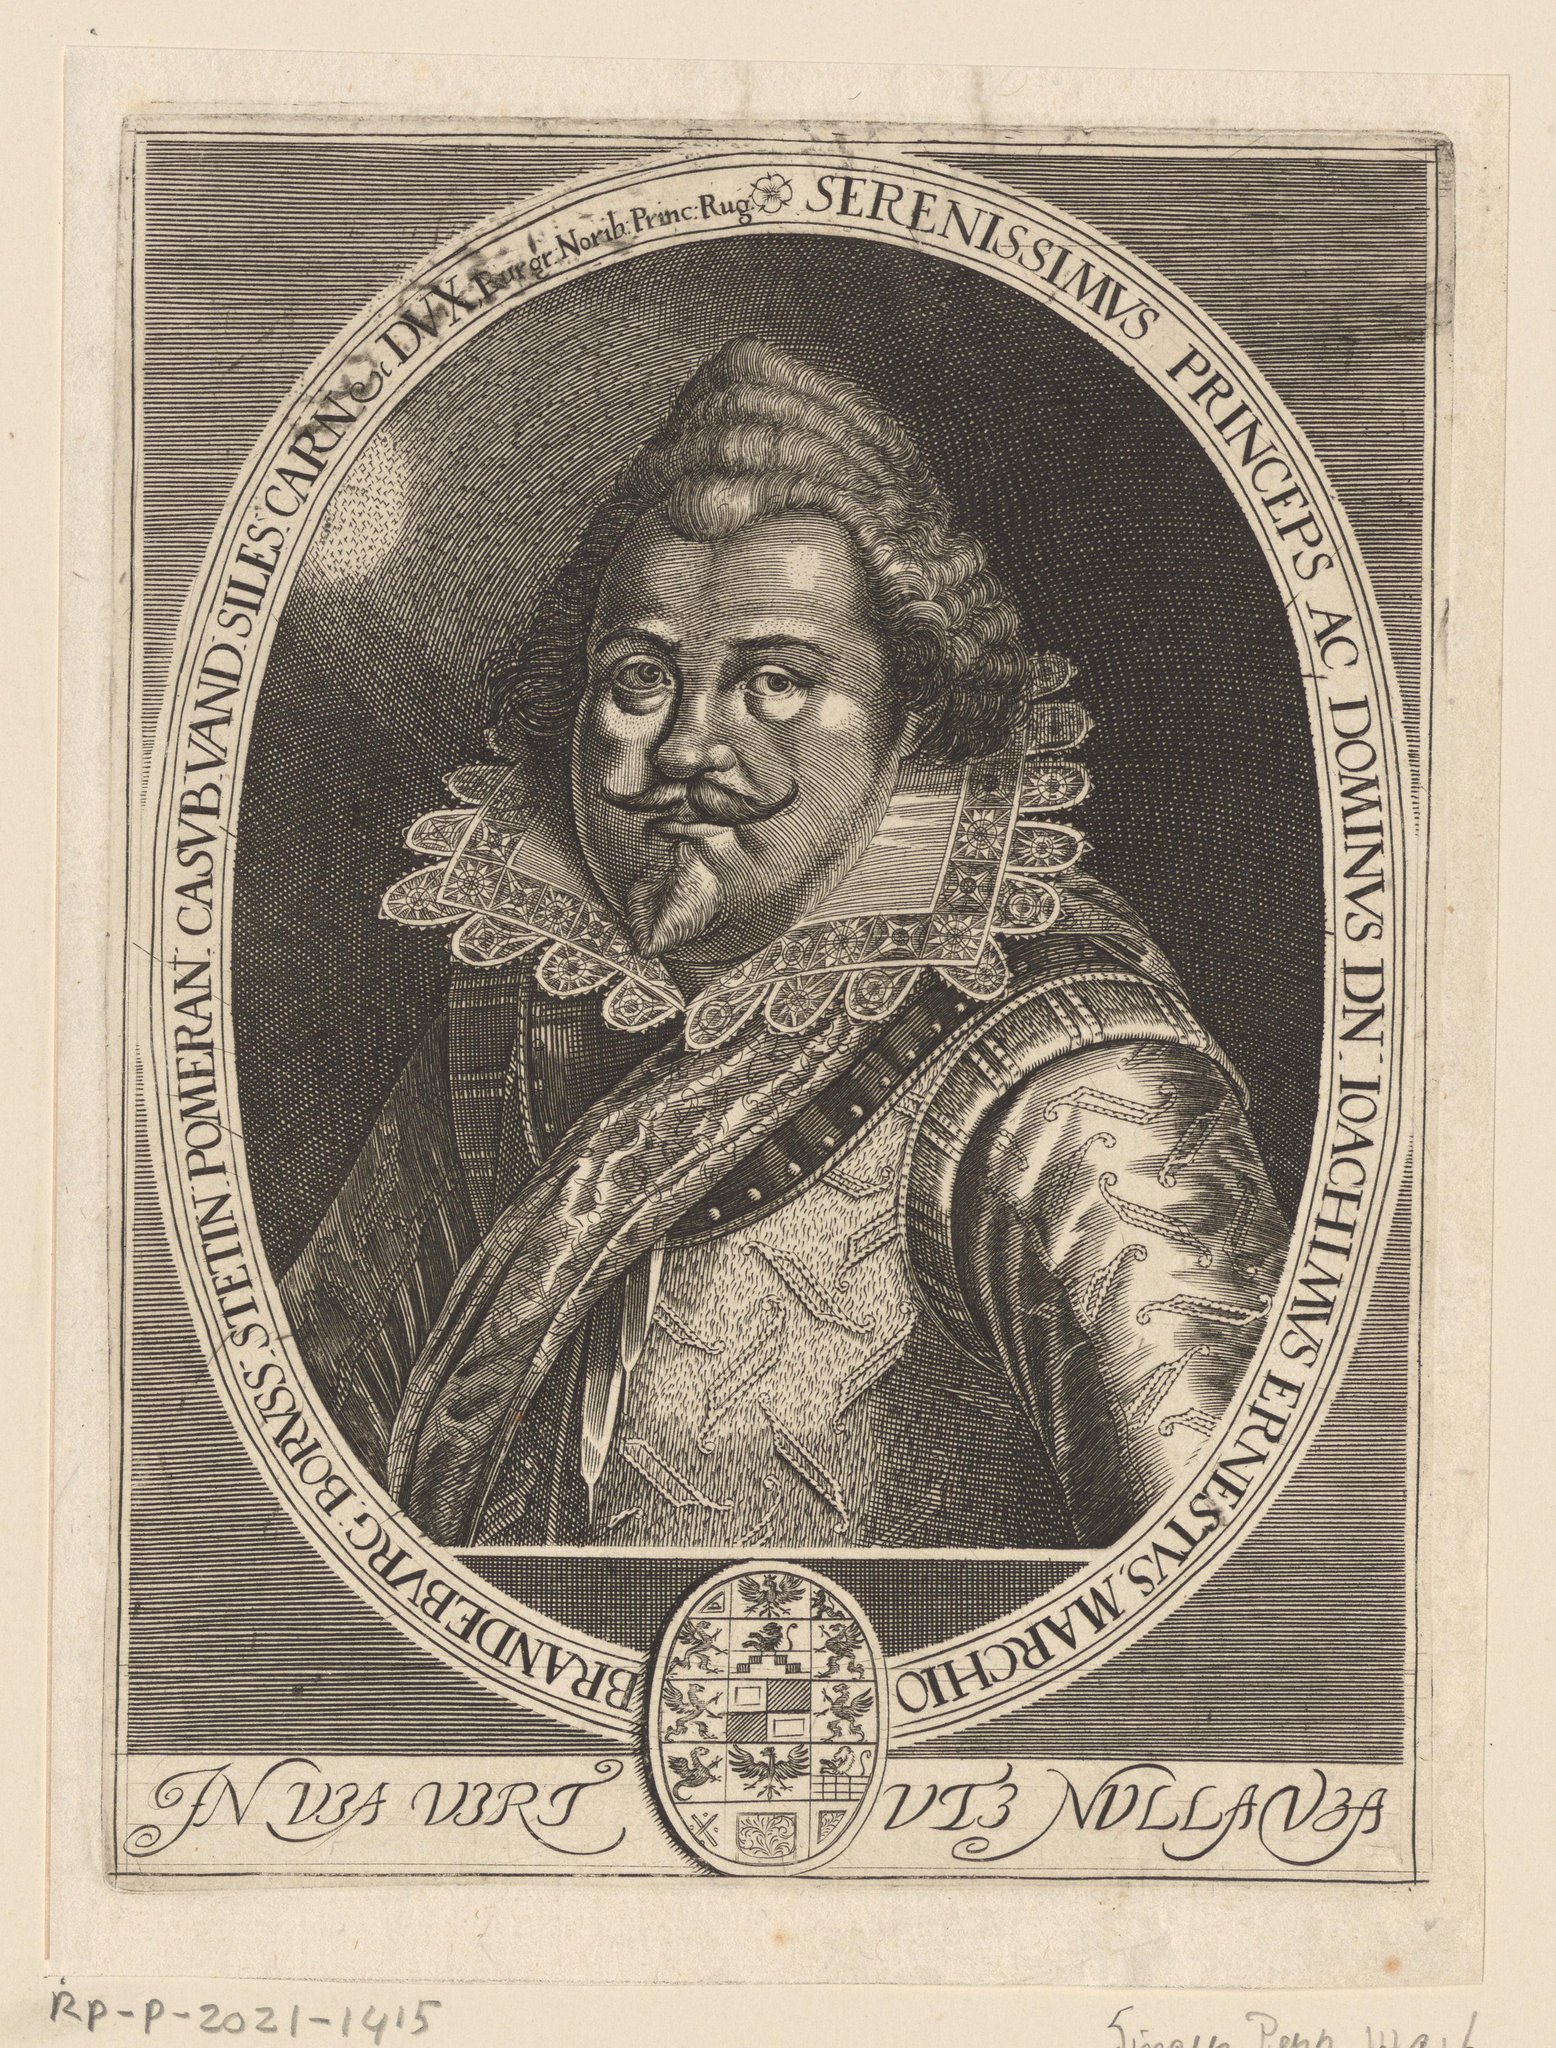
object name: print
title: Portret van Joachim Ernst van Brandenburg-Ansbach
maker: Anonymous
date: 1627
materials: paper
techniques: engraving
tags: historical persons, armorial bearing, heraldry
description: Prent met tekst op verso gebruikt in: Lundorp, Michael Caspar. Laurea Austriaca (...). Frankfurt am Main: Erasmus Kempffer, 1627.